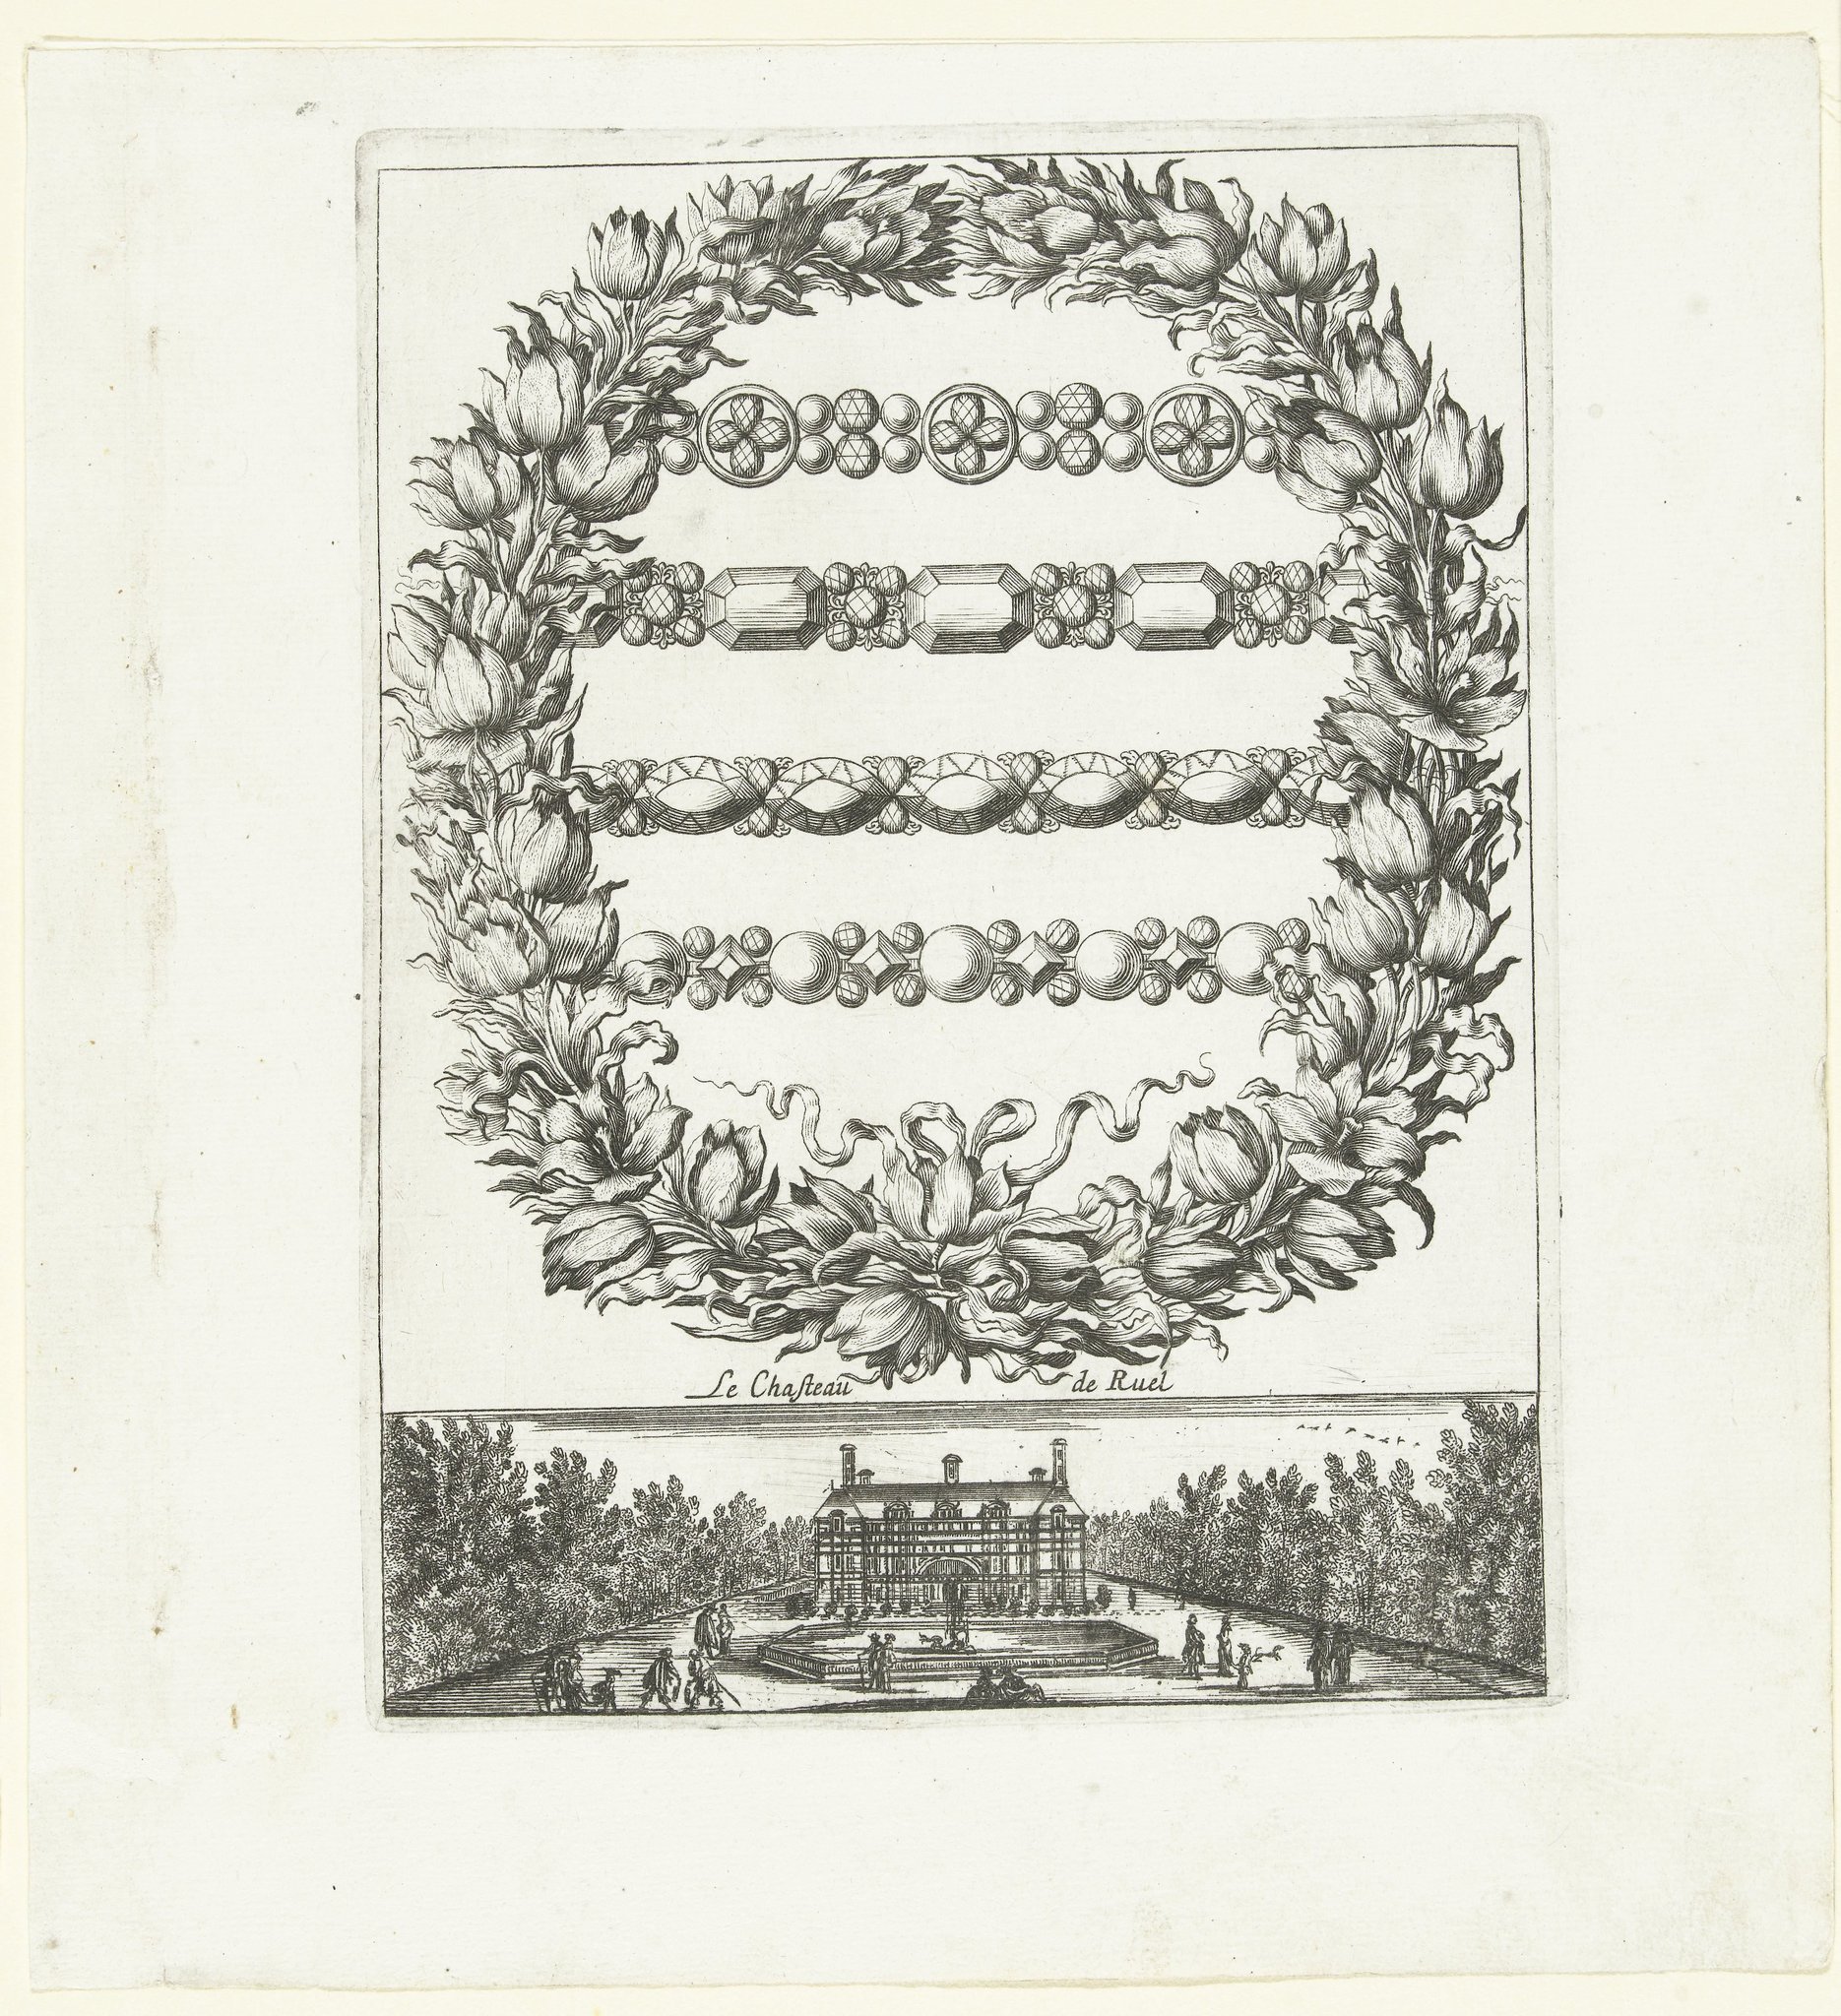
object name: print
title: Le Chasteau de Ruel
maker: balthazar moncornet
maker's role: print maker, publisher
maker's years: 1600-1668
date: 1665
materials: paper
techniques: engraving, etching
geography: france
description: De kettingen zijn gedecoreerd met edelstenen in verschillende maten. Onderaan een uitzicht op het Kasteel van Ruel in Frankrijk.